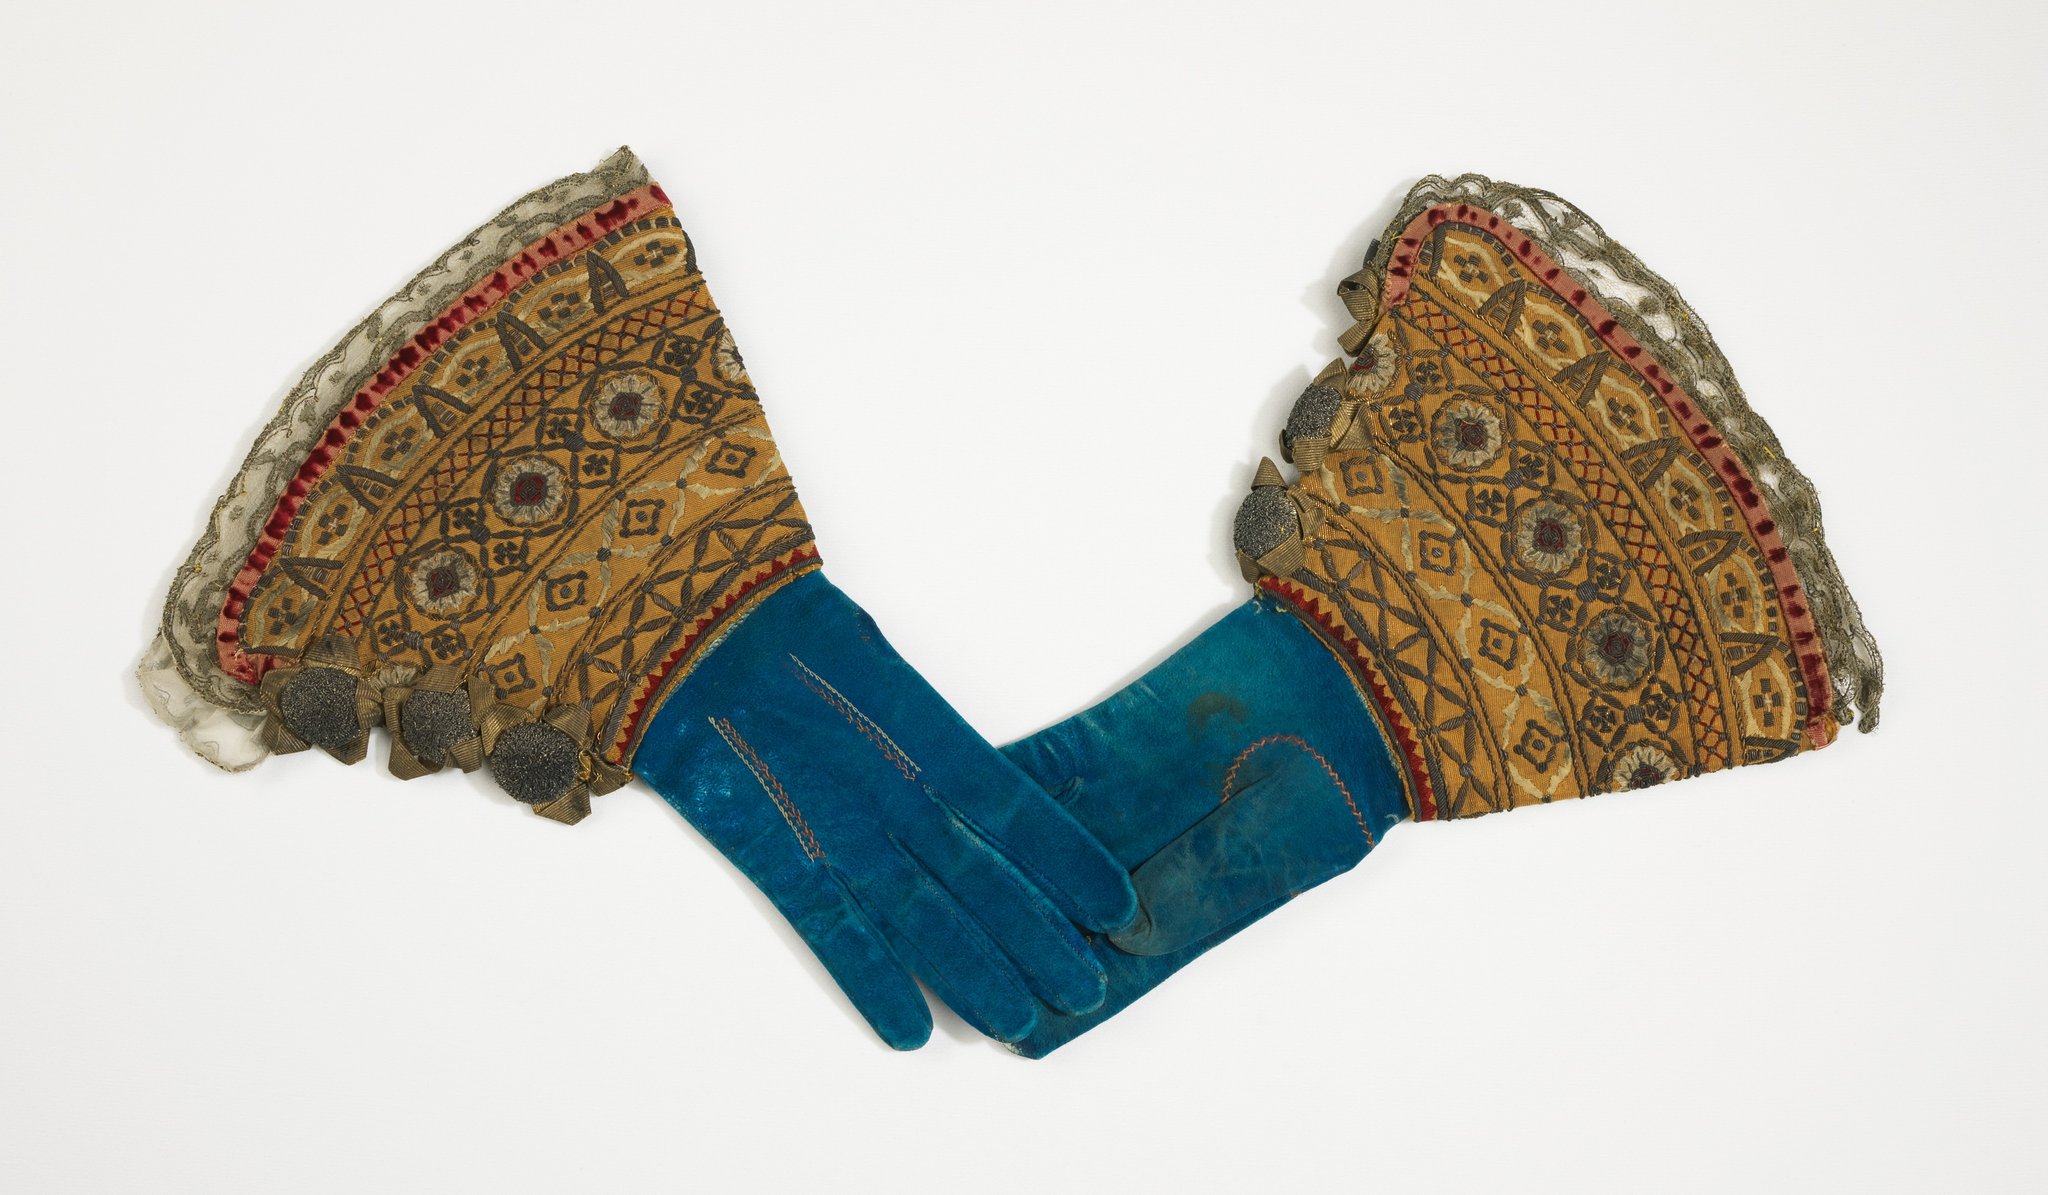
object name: gauntlet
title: Gauntlets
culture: british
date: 1690-1710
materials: leather, metal, silk